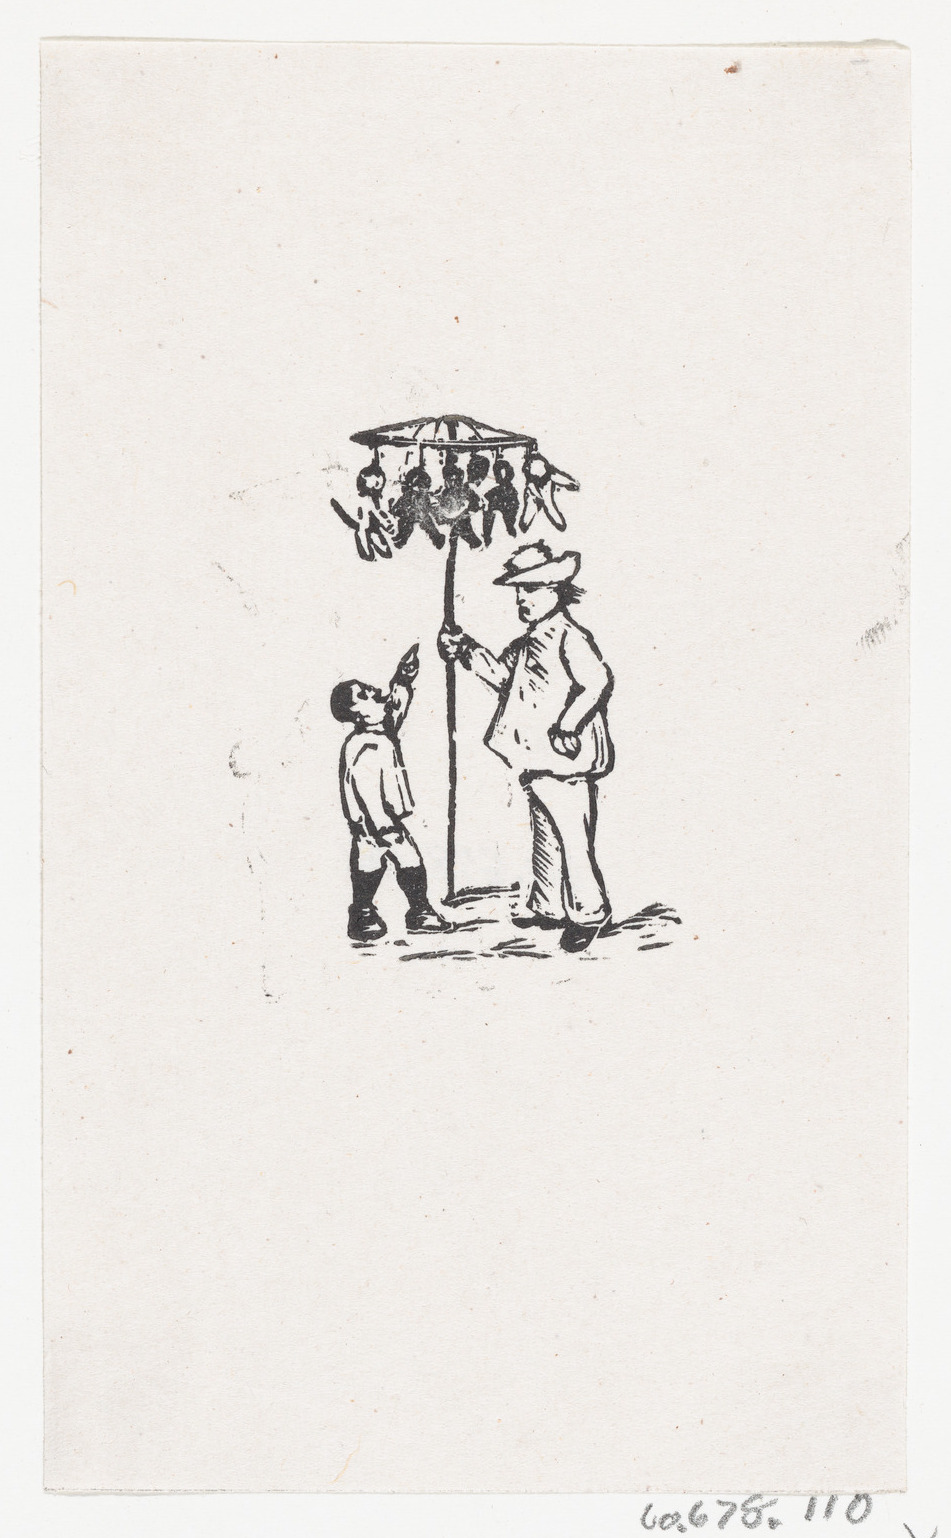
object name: print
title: A vendor selling toys to a child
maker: josé guadalupe posada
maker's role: artist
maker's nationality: mexican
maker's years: 1852-1913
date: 1880-1910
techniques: lithography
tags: boys,men,toys